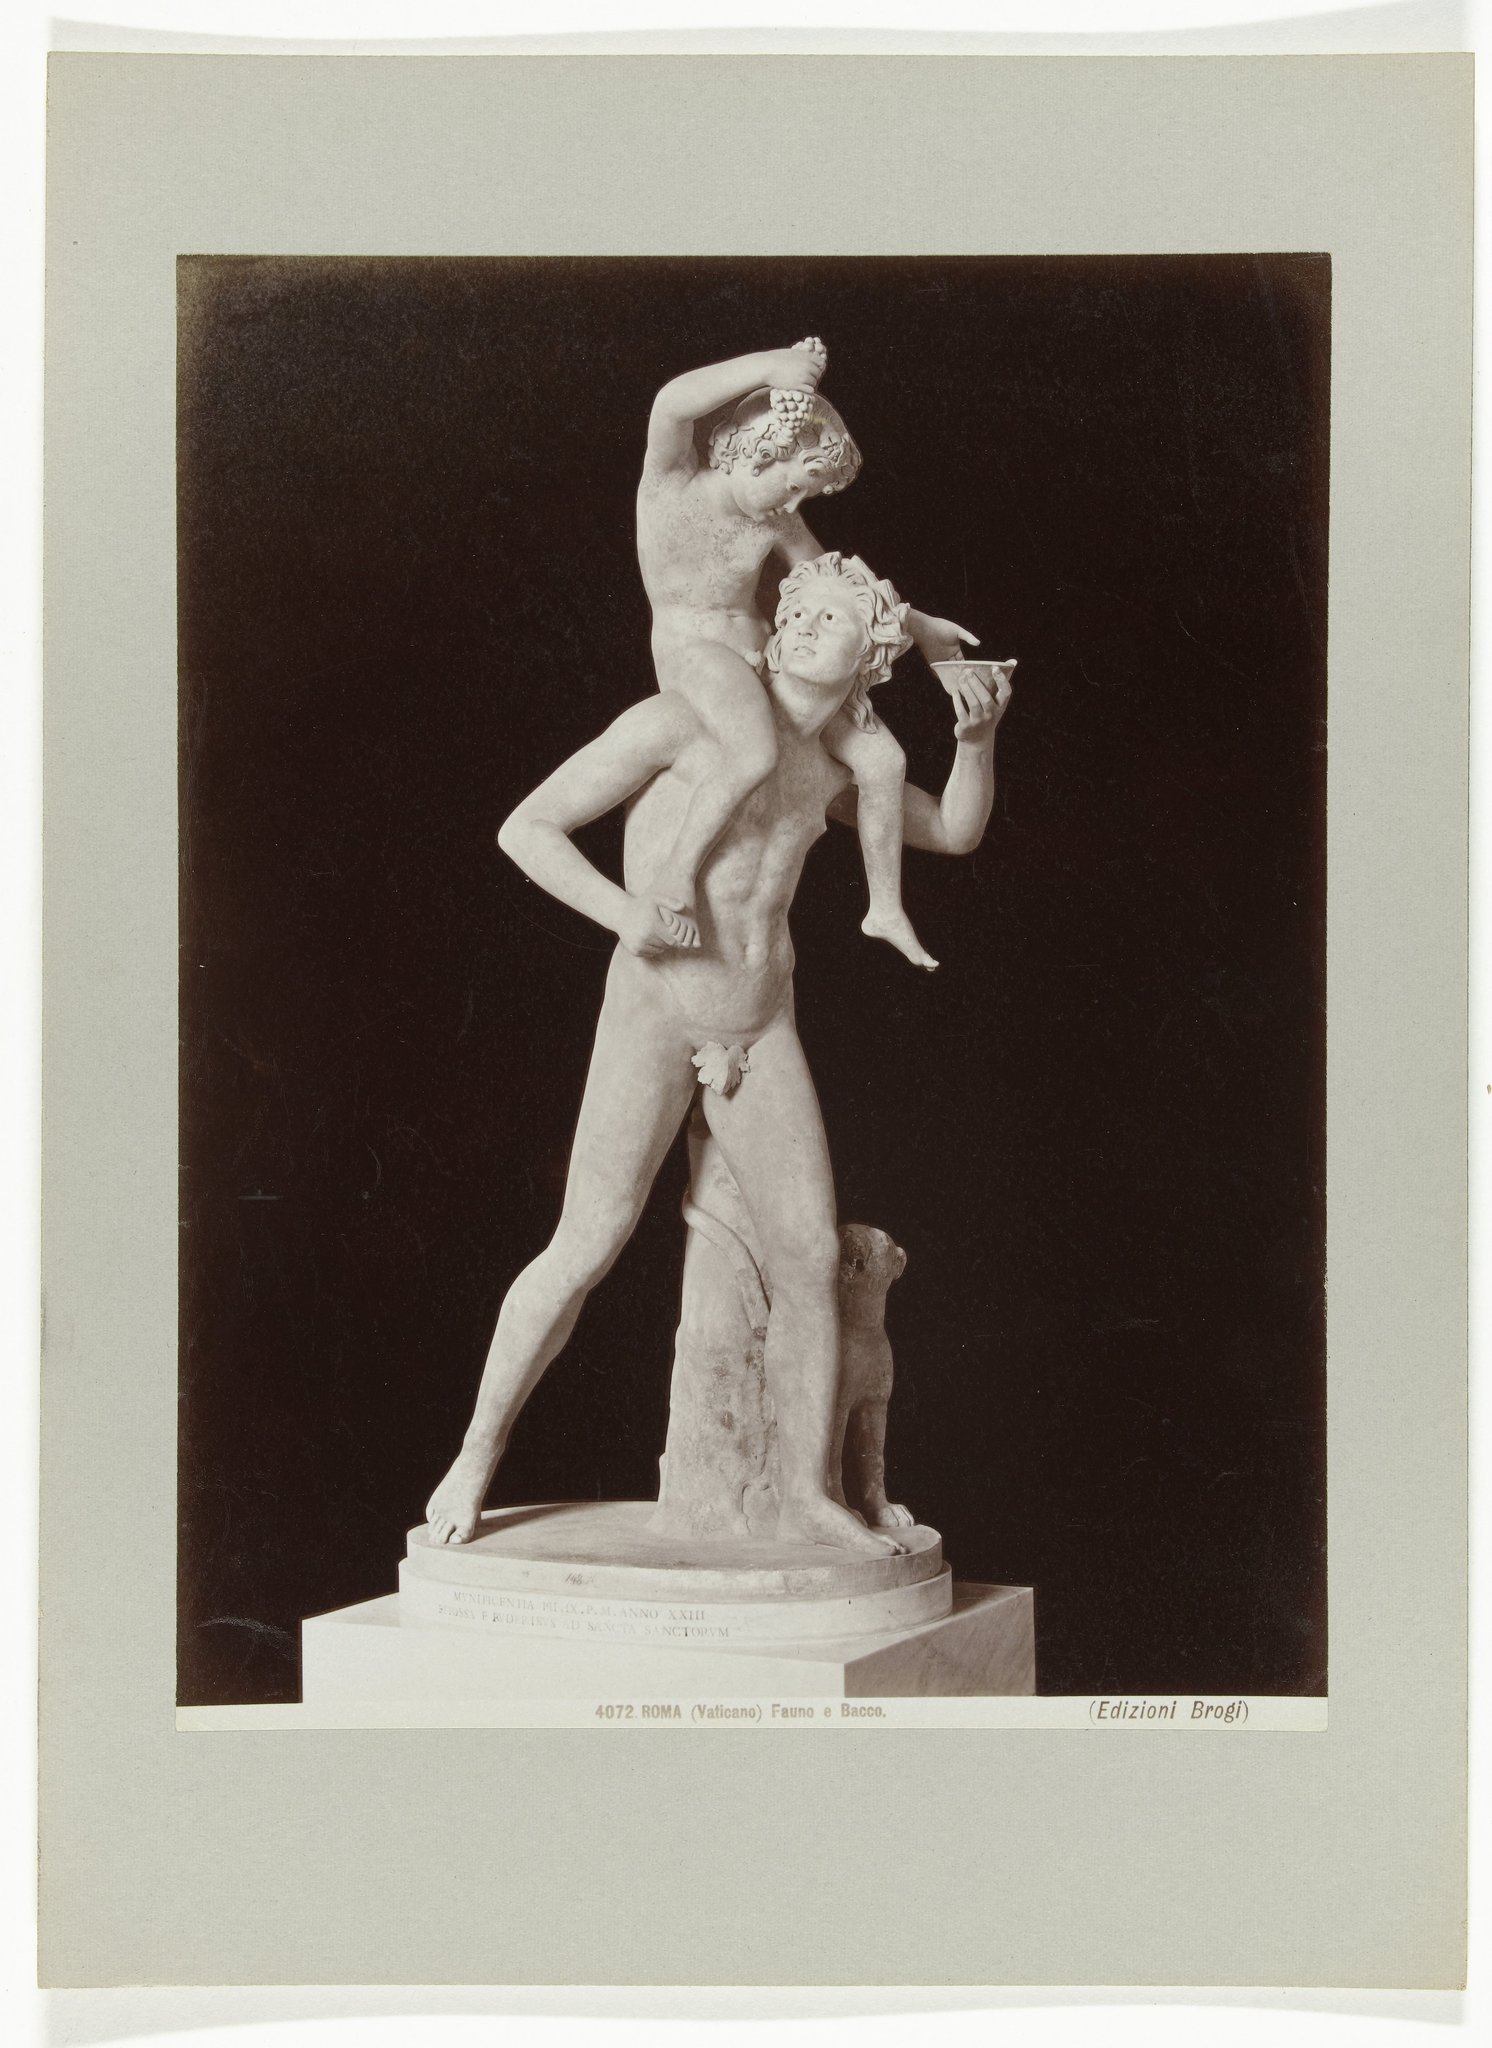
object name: photograph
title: 4072. Roma (Vaticano) Fauno e Bacco.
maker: Anonymous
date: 1880-1904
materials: cardboard, paper, photographic support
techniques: albumen print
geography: rome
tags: rome